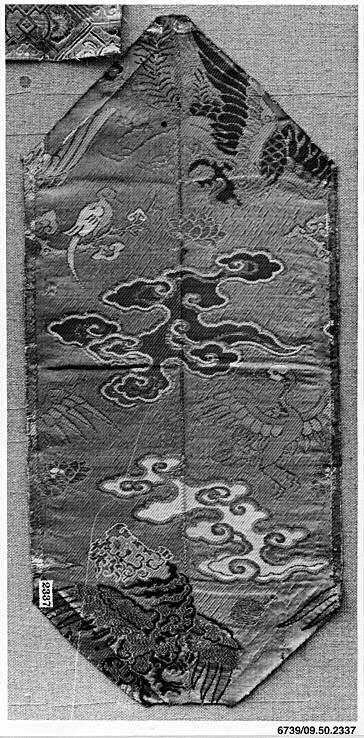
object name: piece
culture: japanese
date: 1601-1800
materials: silk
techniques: brocade